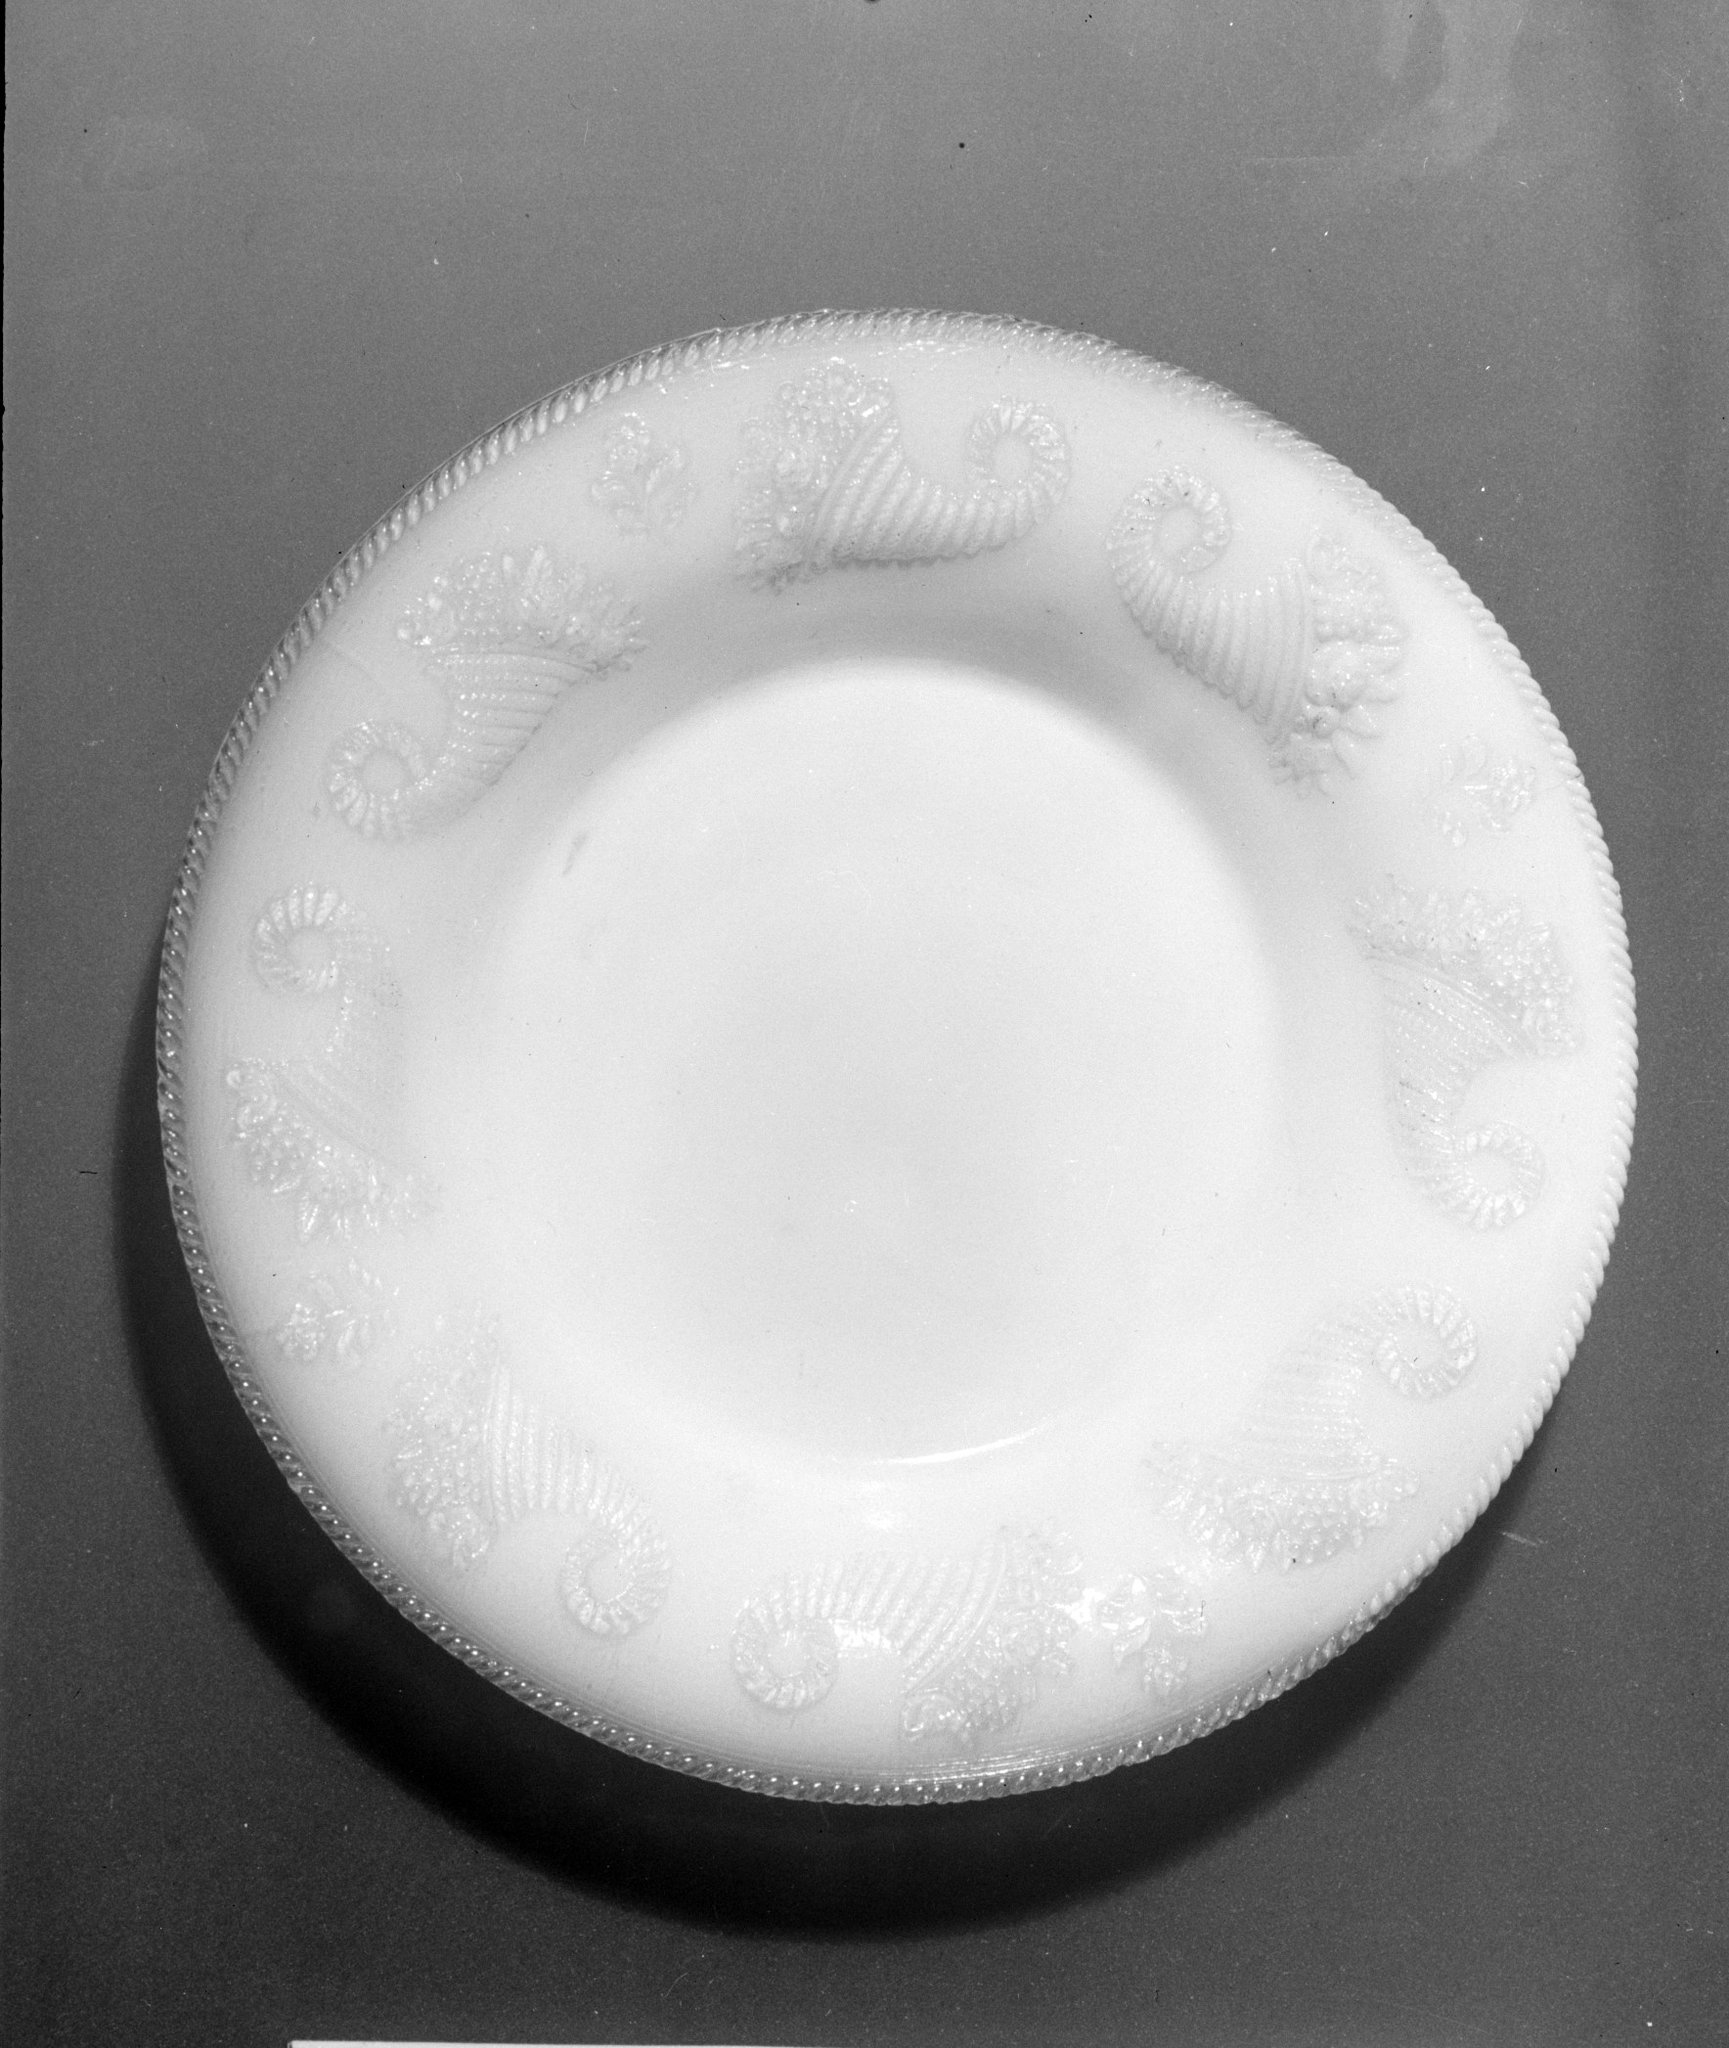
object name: plate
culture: american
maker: new england glass company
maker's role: maker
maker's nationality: american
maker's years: 1818-1888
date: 1830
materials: glass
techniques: pressed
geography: united states